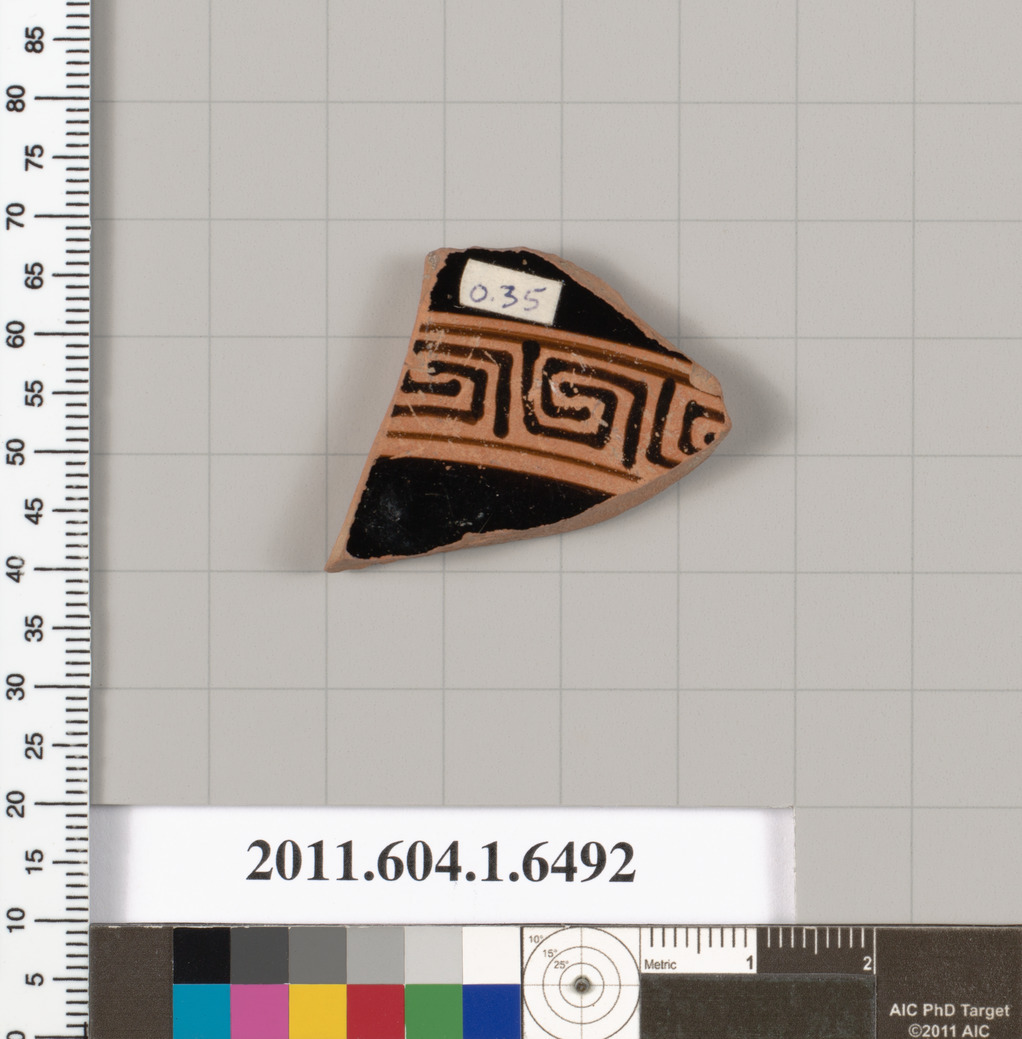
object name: kylix fragment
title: Terracotta fragment of a kylix (drinking cup)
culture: greek, attic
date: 490-480 BCE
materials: terracotta